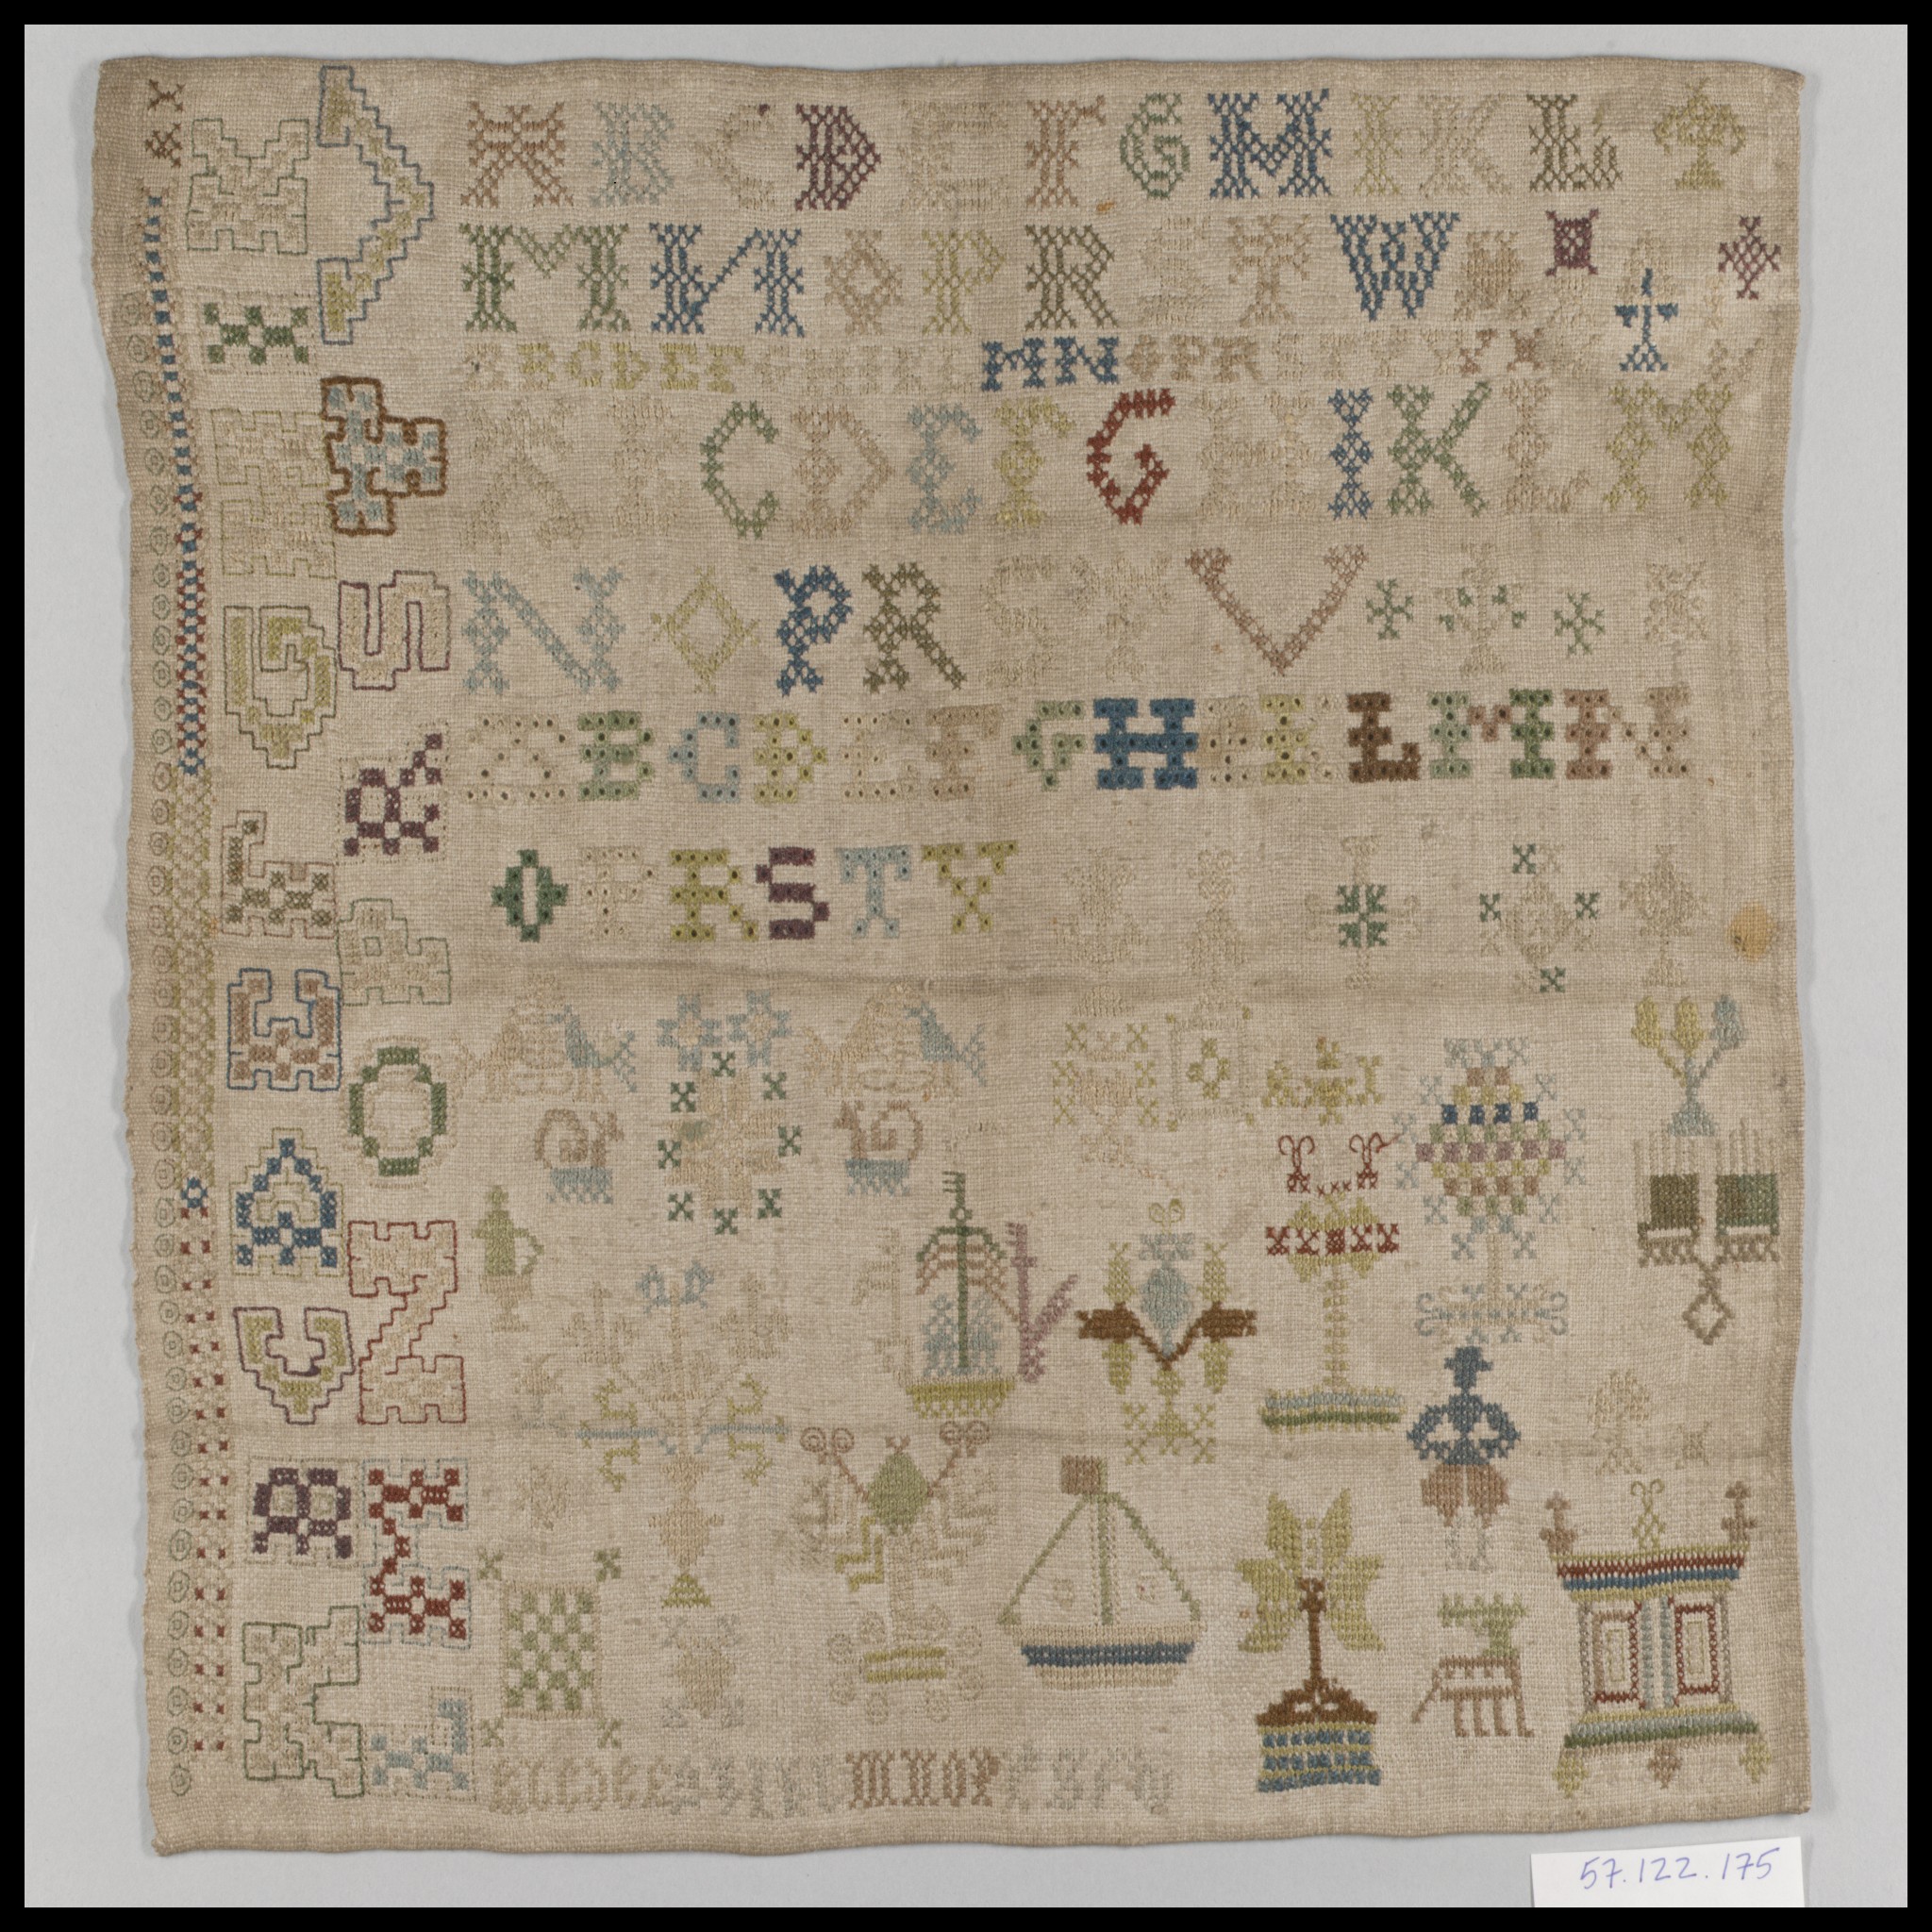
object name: sampler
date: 1701-1800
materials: linen, silk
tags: human figures